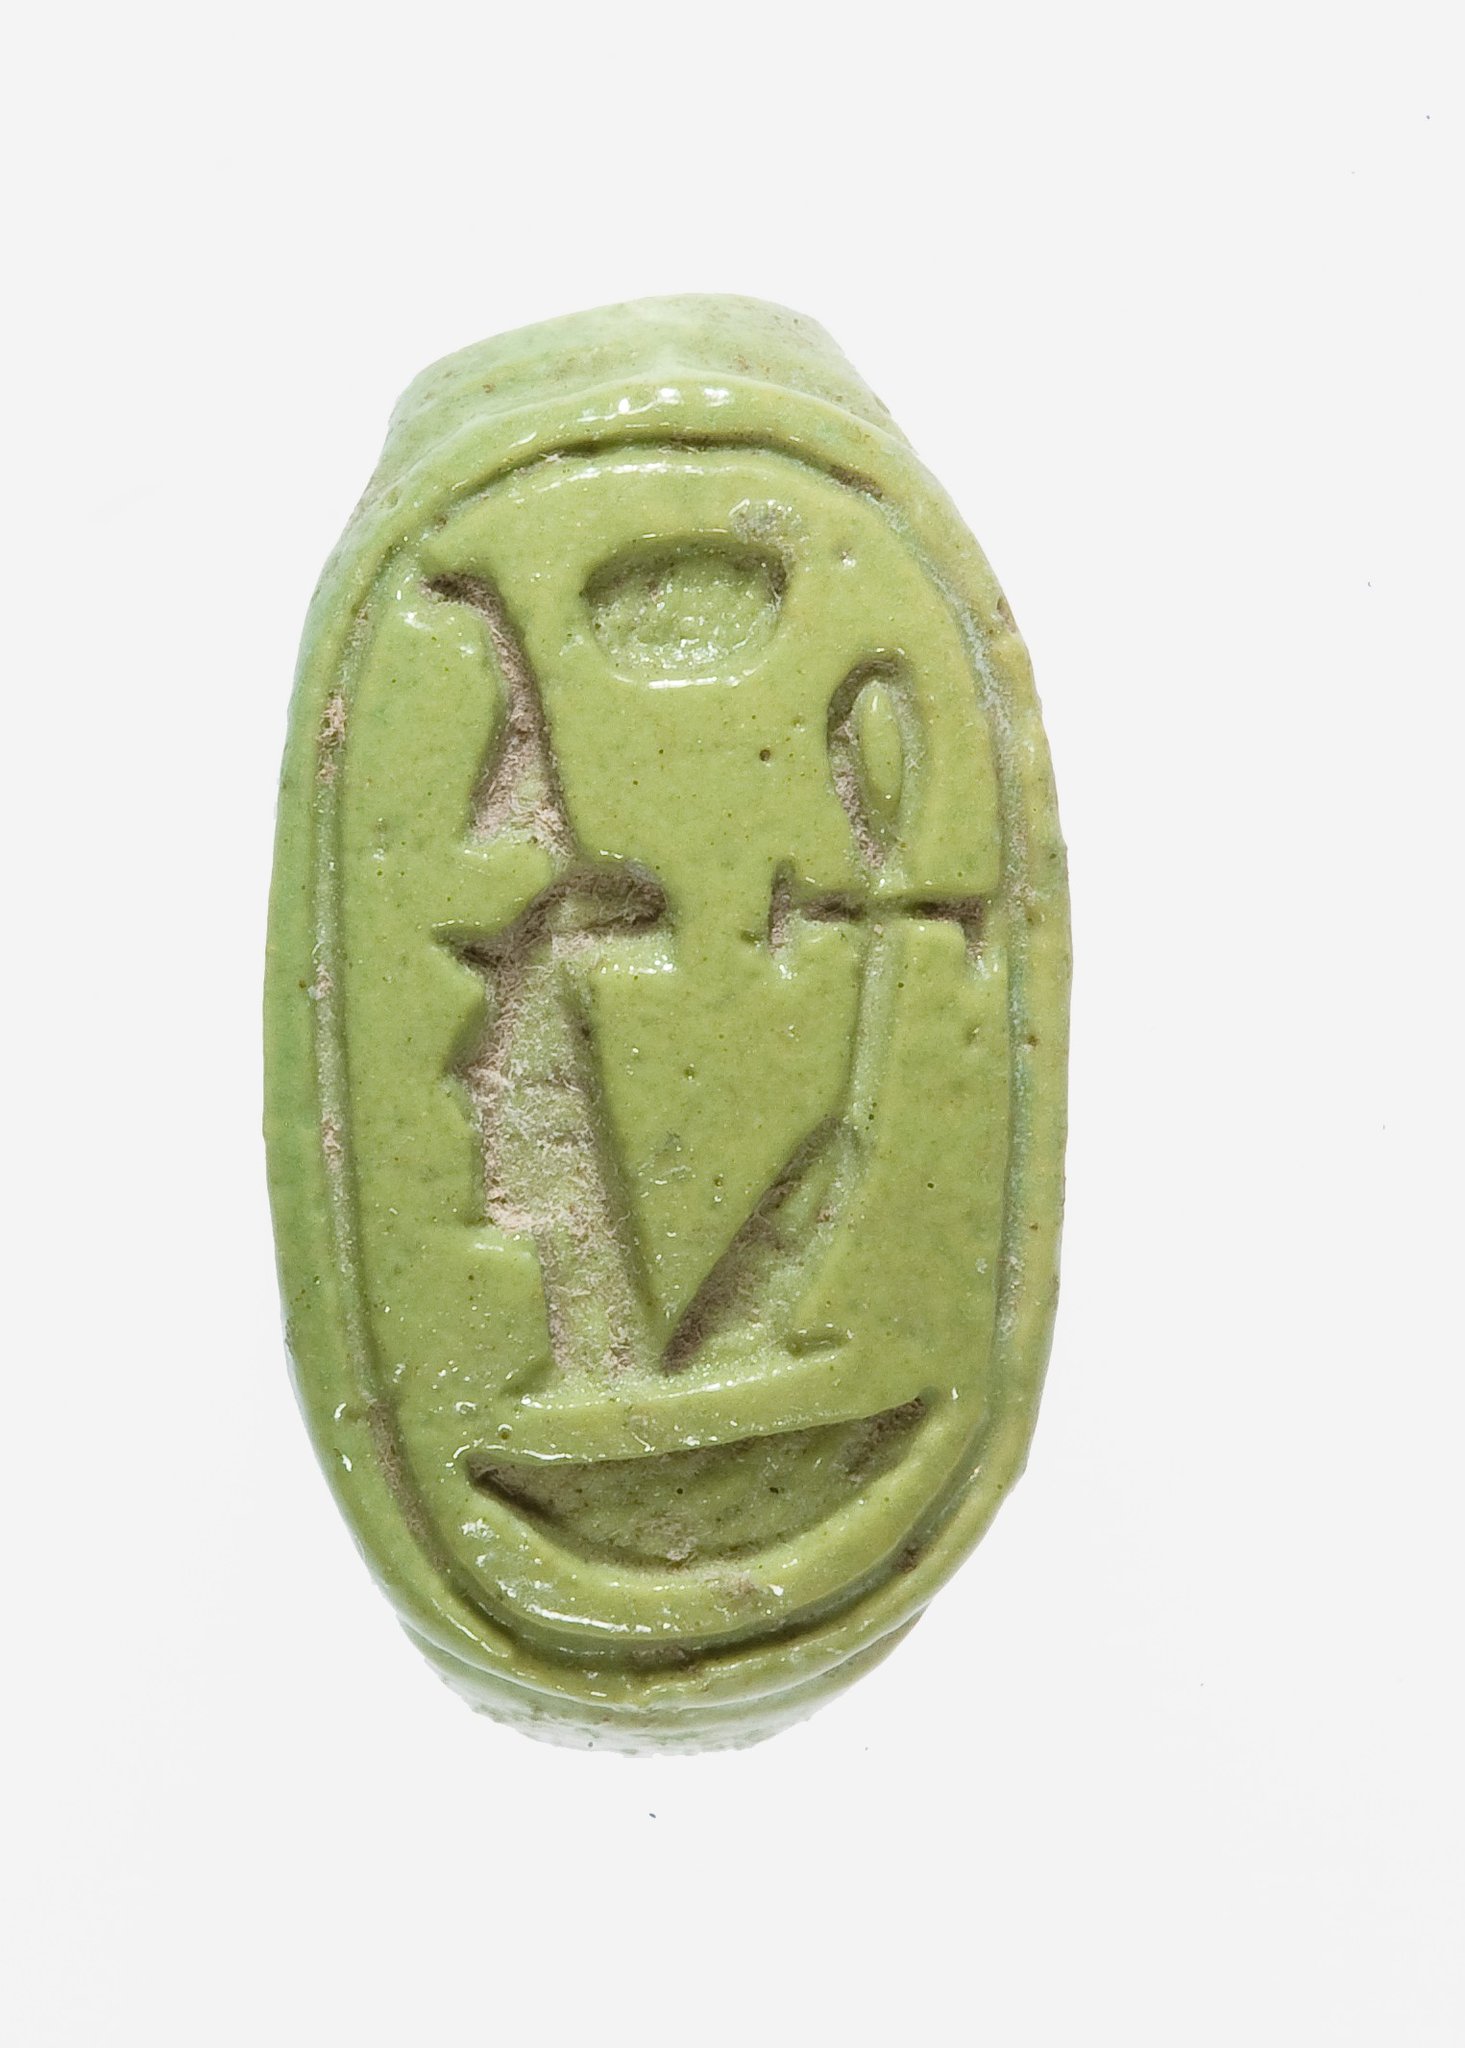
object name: ring, amenhotep iii, nebmaatre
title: Ring Inscribed with the Throne Name of Amenhotep III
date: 1390-1352 BCE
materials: faience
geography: egypt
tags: hieroglyphs